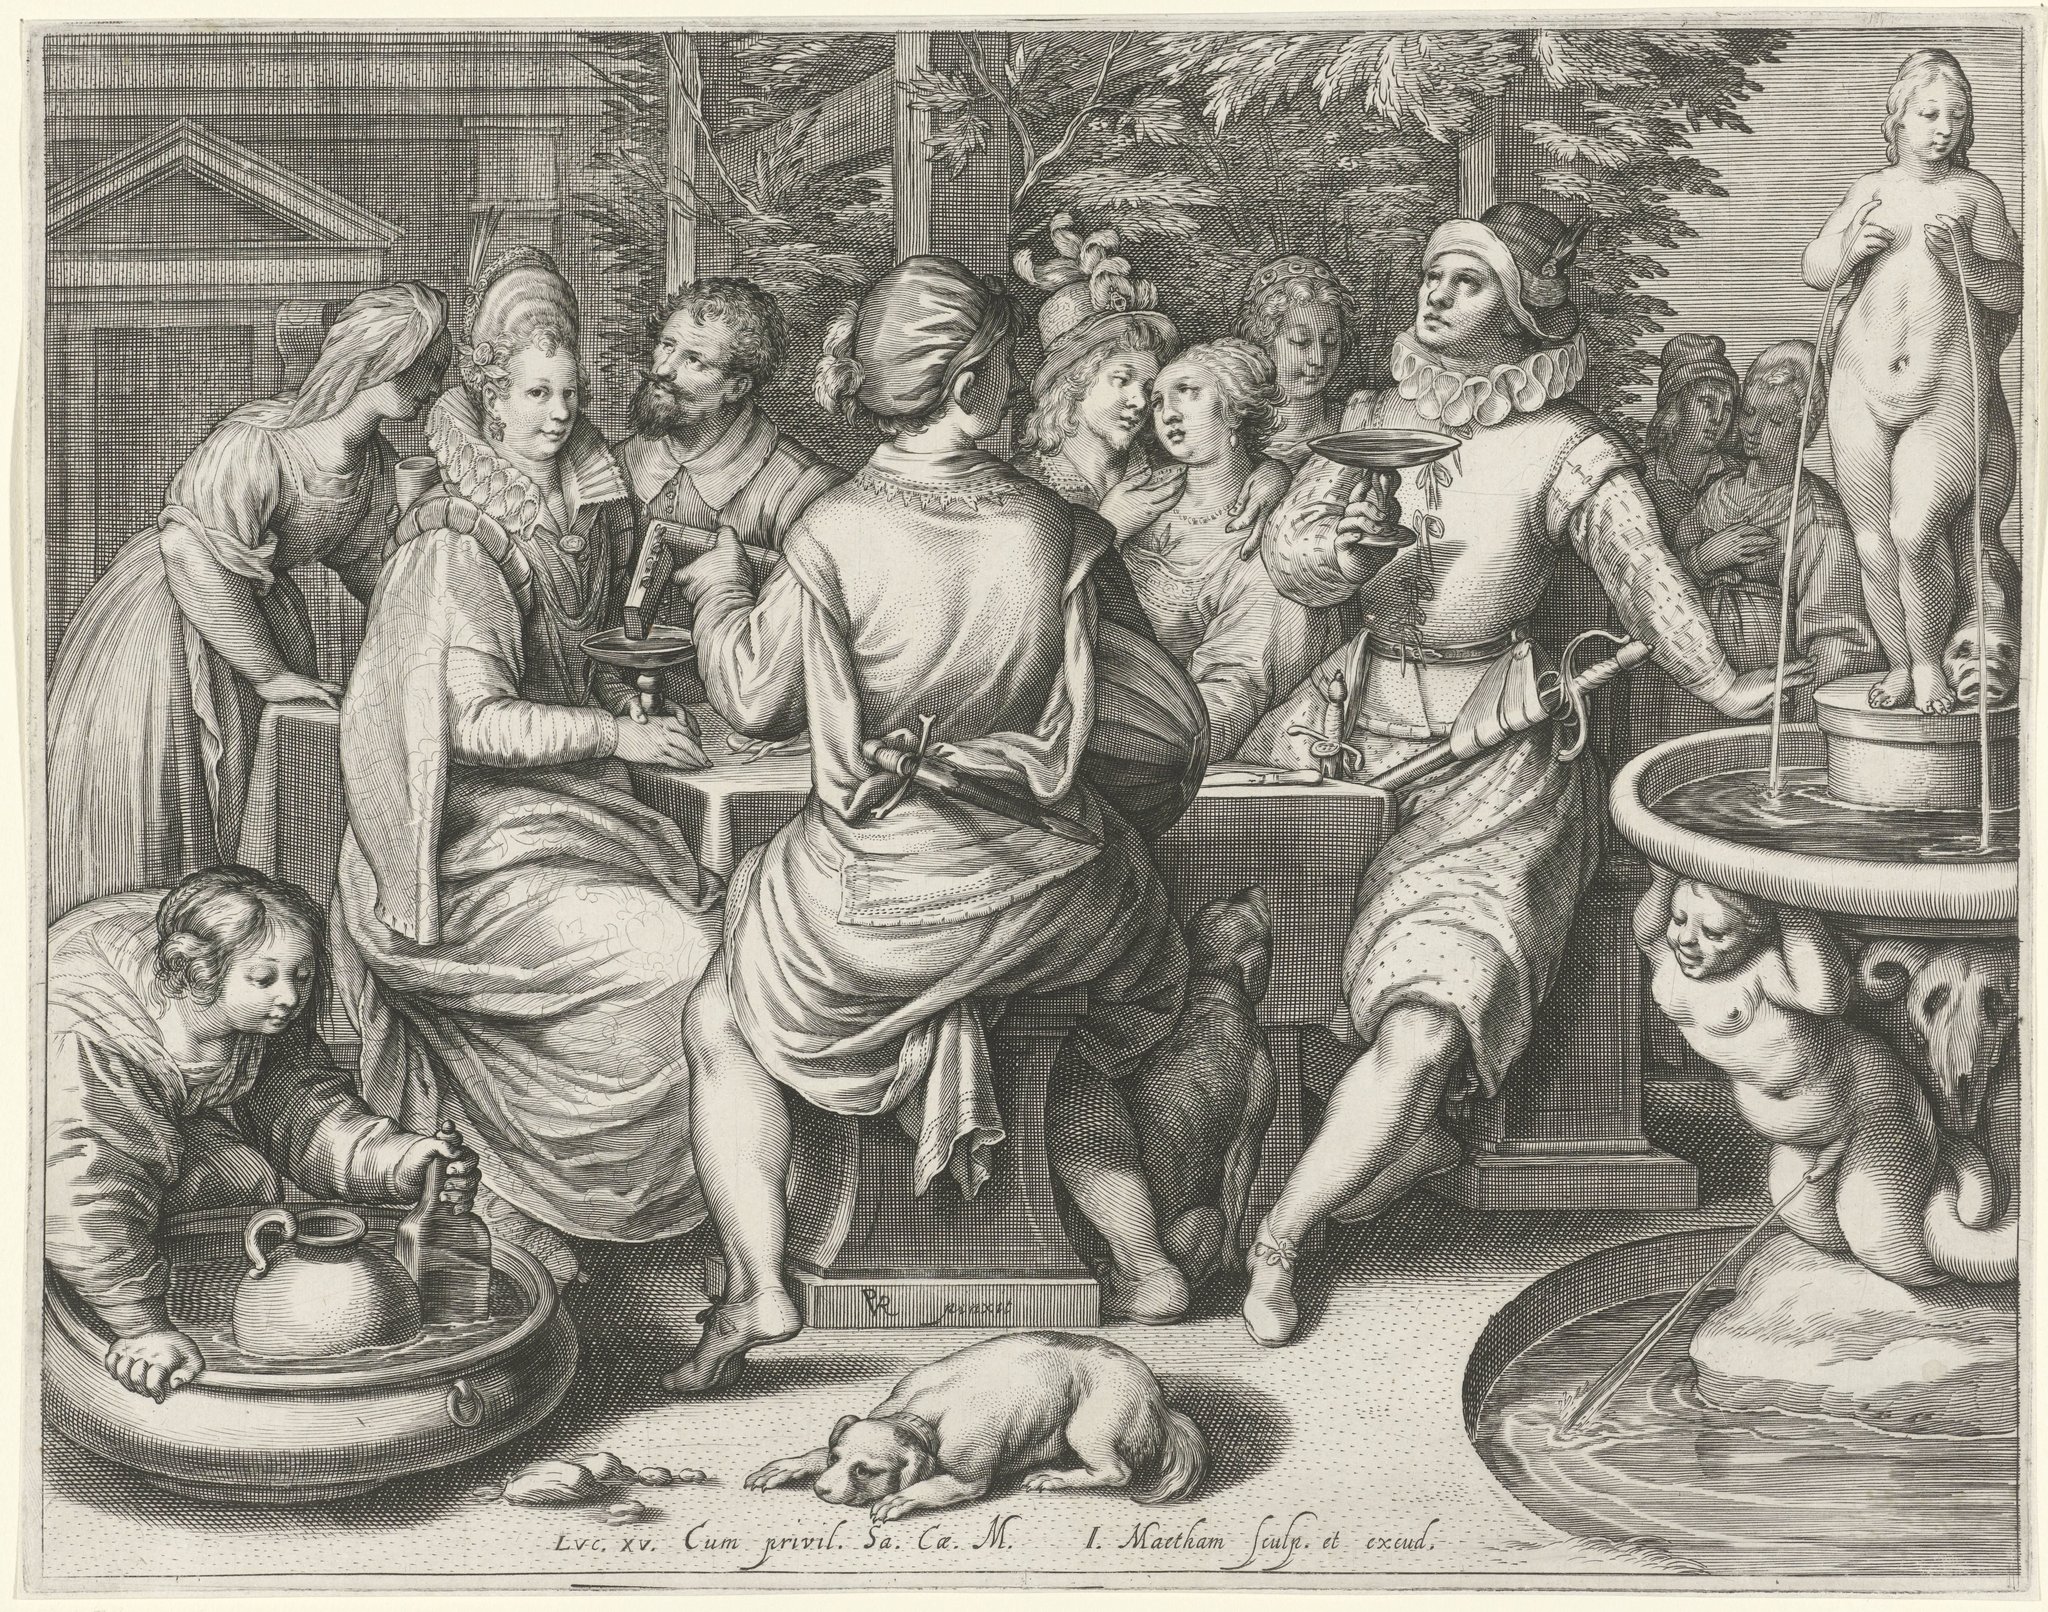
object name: print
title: De verloren zoon zijn geld verkwistend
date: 1601-1606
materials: paper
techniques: engraving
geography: haarlem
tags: garden fountain, the prodigal son in the midst of prostitutes feasting and dissipating his patrimony, usually in a brothel or inn, private festivities, merry company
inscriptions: collector's mark: Lugt 240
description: Een drinkend gezelschap aan tafel. Een man op de rug gezien bespeelt een luit. Rechts een fontein. Scène uit het bijbelse verhaal van de verloren zoon, waarin de jongeman zijn geld verbrast aan lichtekooien.